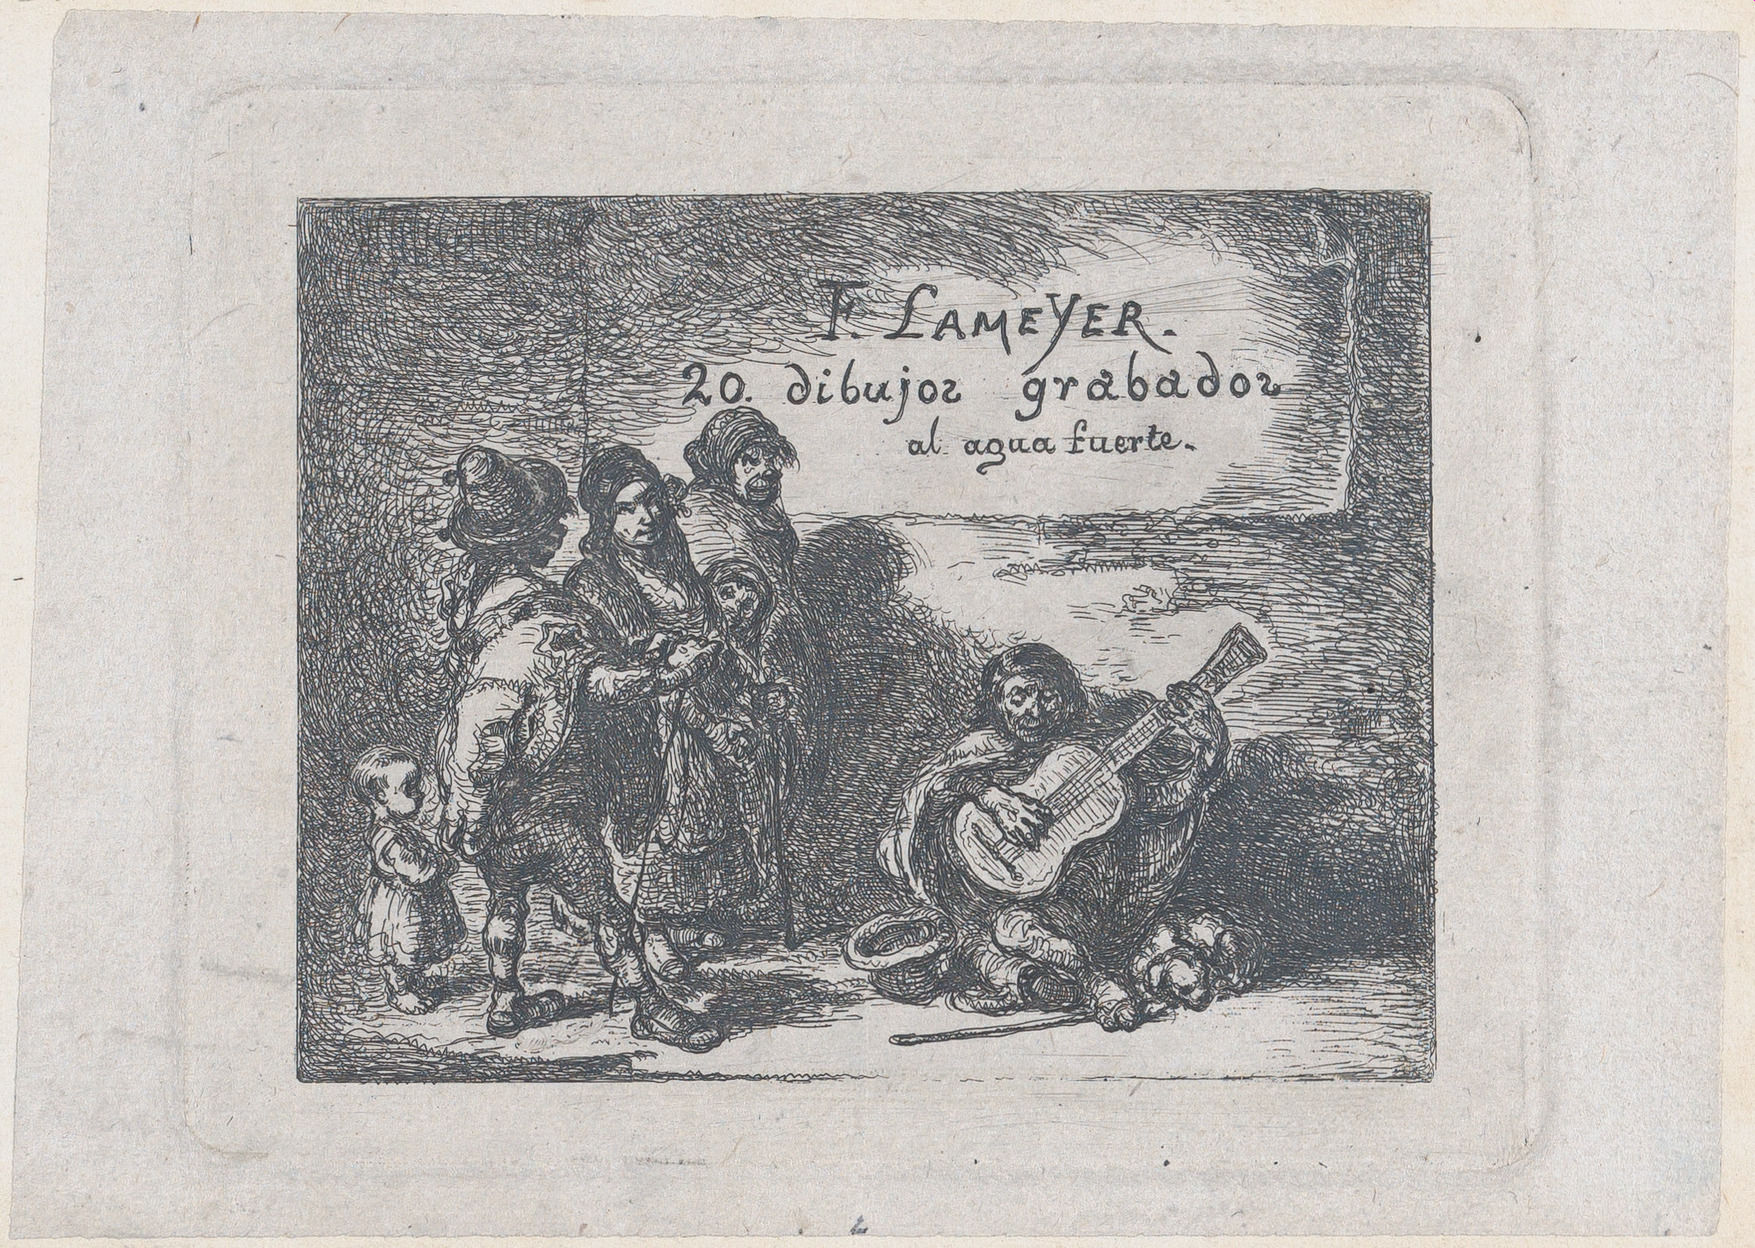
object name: print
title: Title page to the series of 20 prints of customs and pastimes of the Spanish people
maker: francisco lameyer y berenguer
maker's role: artist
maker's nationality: spanish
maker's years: 1825-1877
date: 1850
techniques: etching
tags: girls,men,women,guitars,musicians